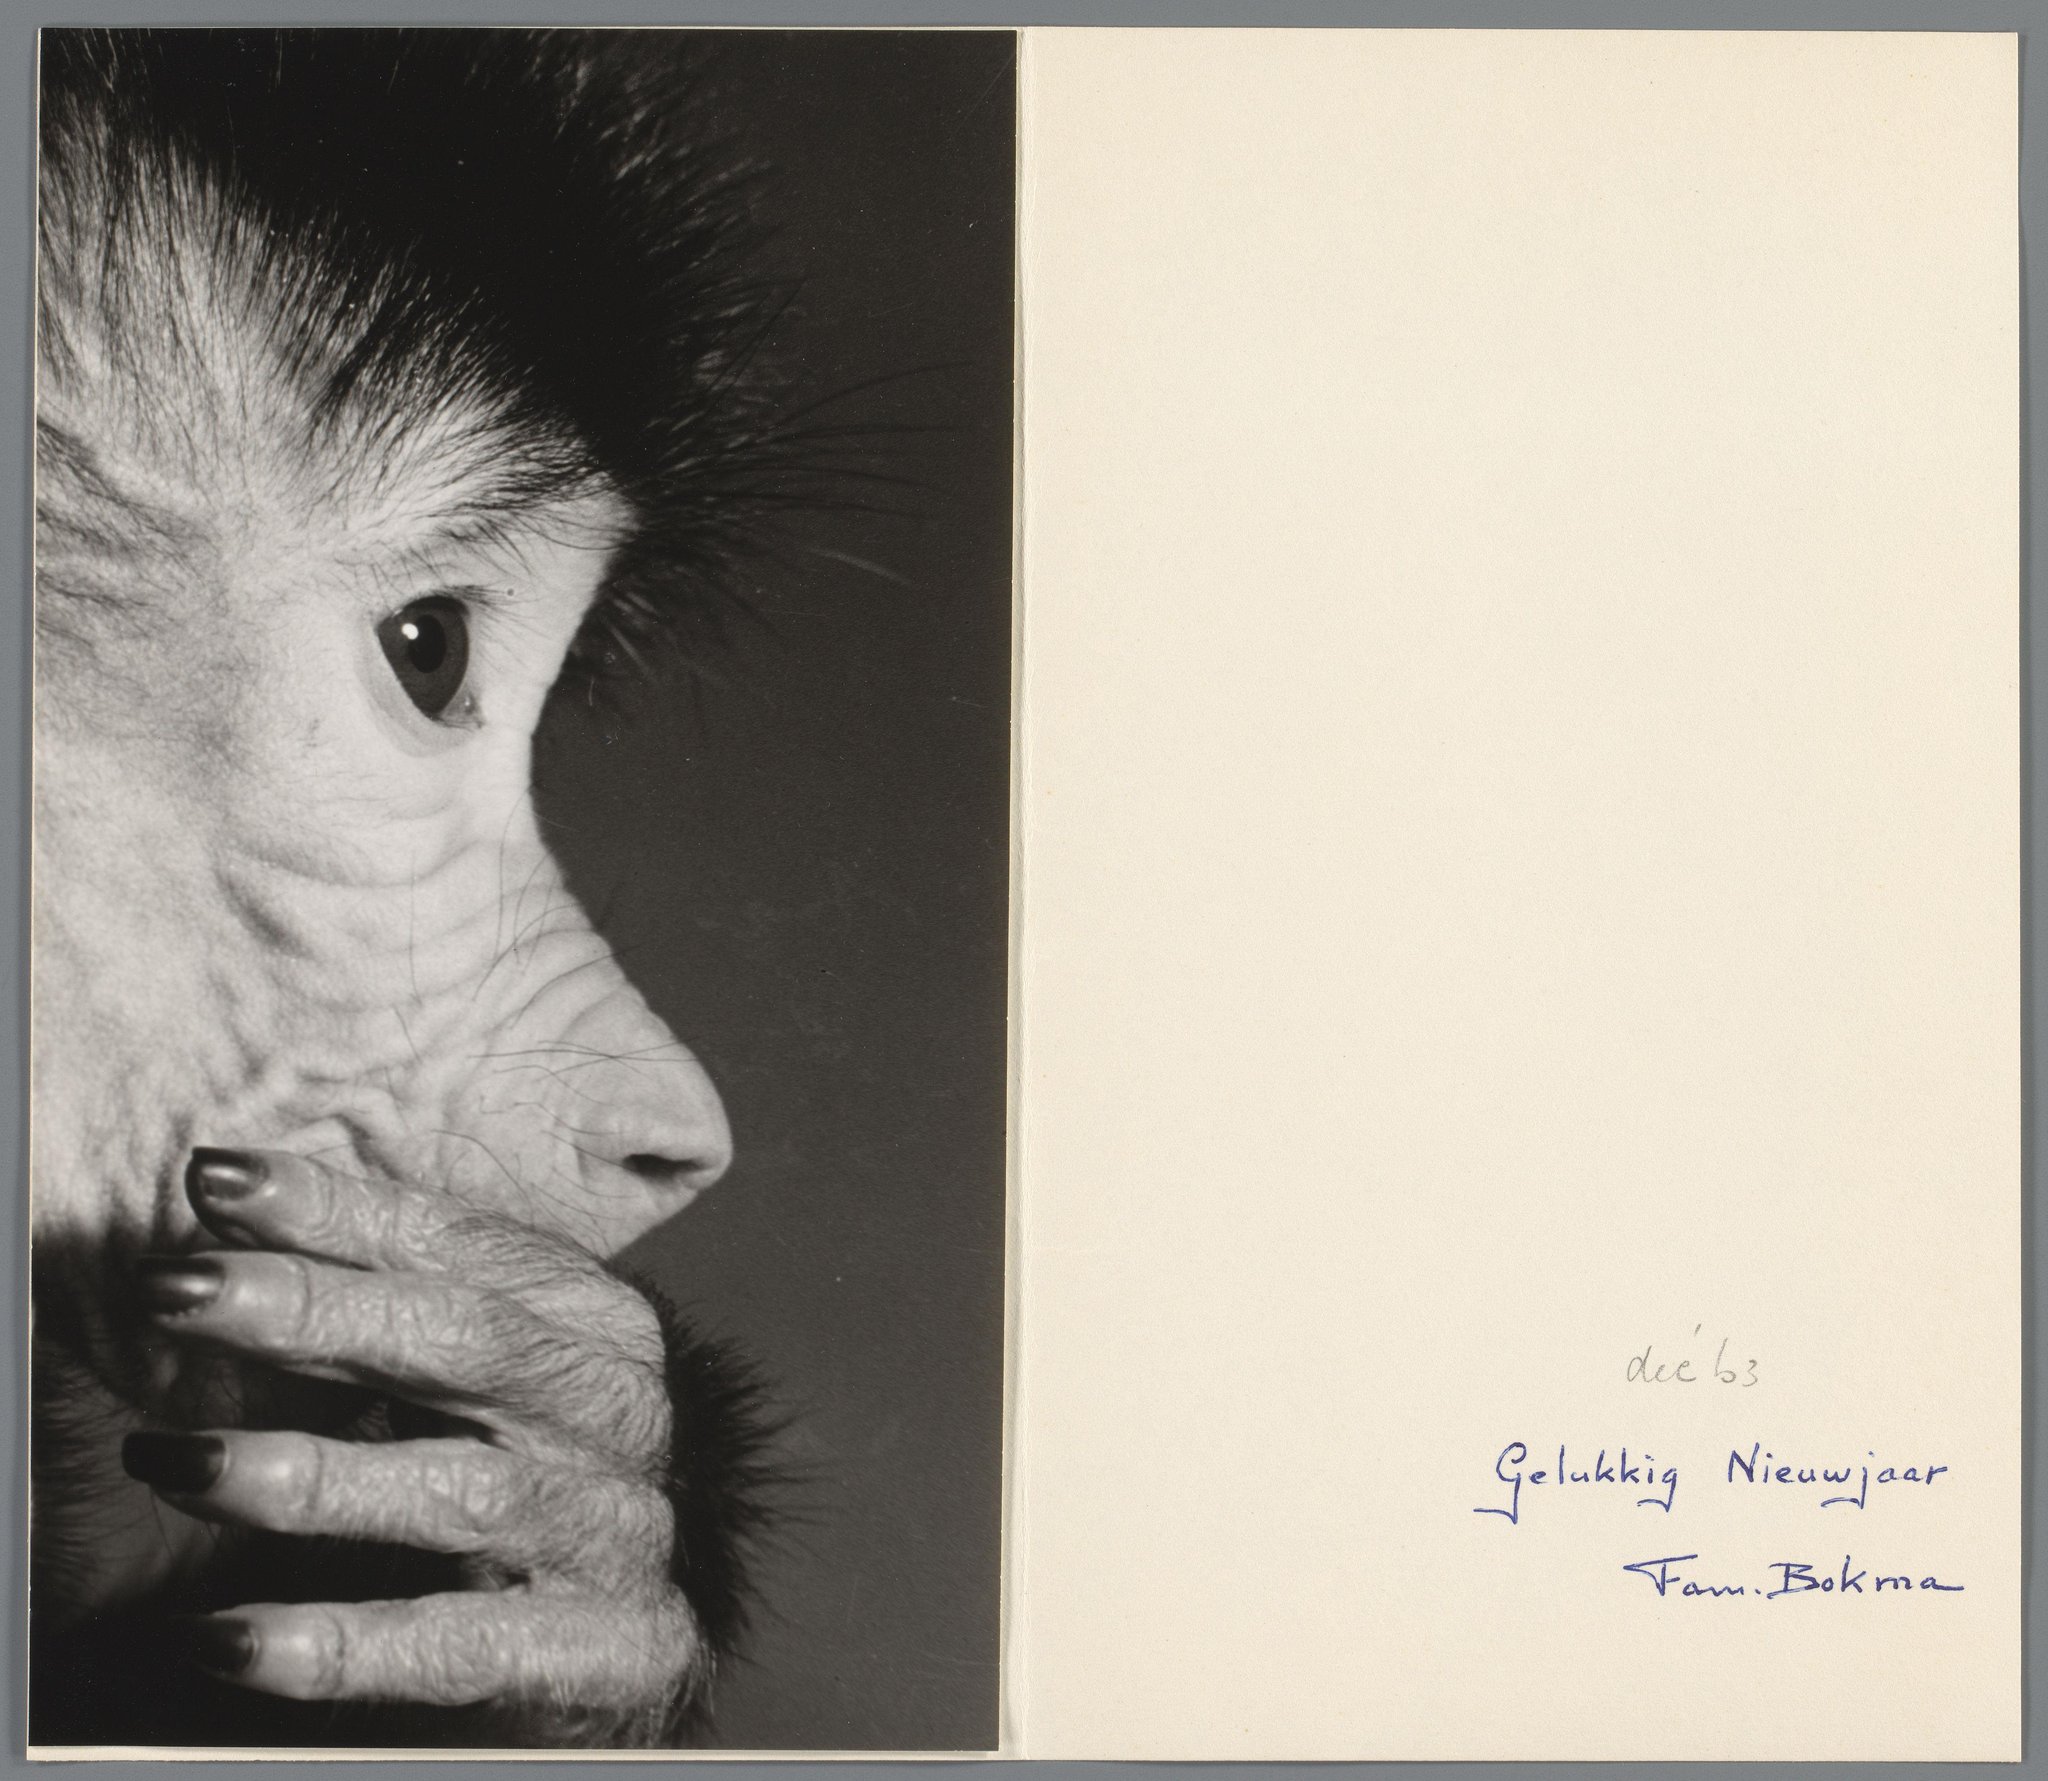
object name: new year card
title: Nieuwjaarswens voor 1964 met kop van een aap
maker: Anonymous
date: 1963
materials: paper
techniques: gelatin silver print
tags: l.j. hartkamp, monkeys, apes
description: Nieuwjaarswens van de familie Bokma gericht aan Bert Hartkamp.